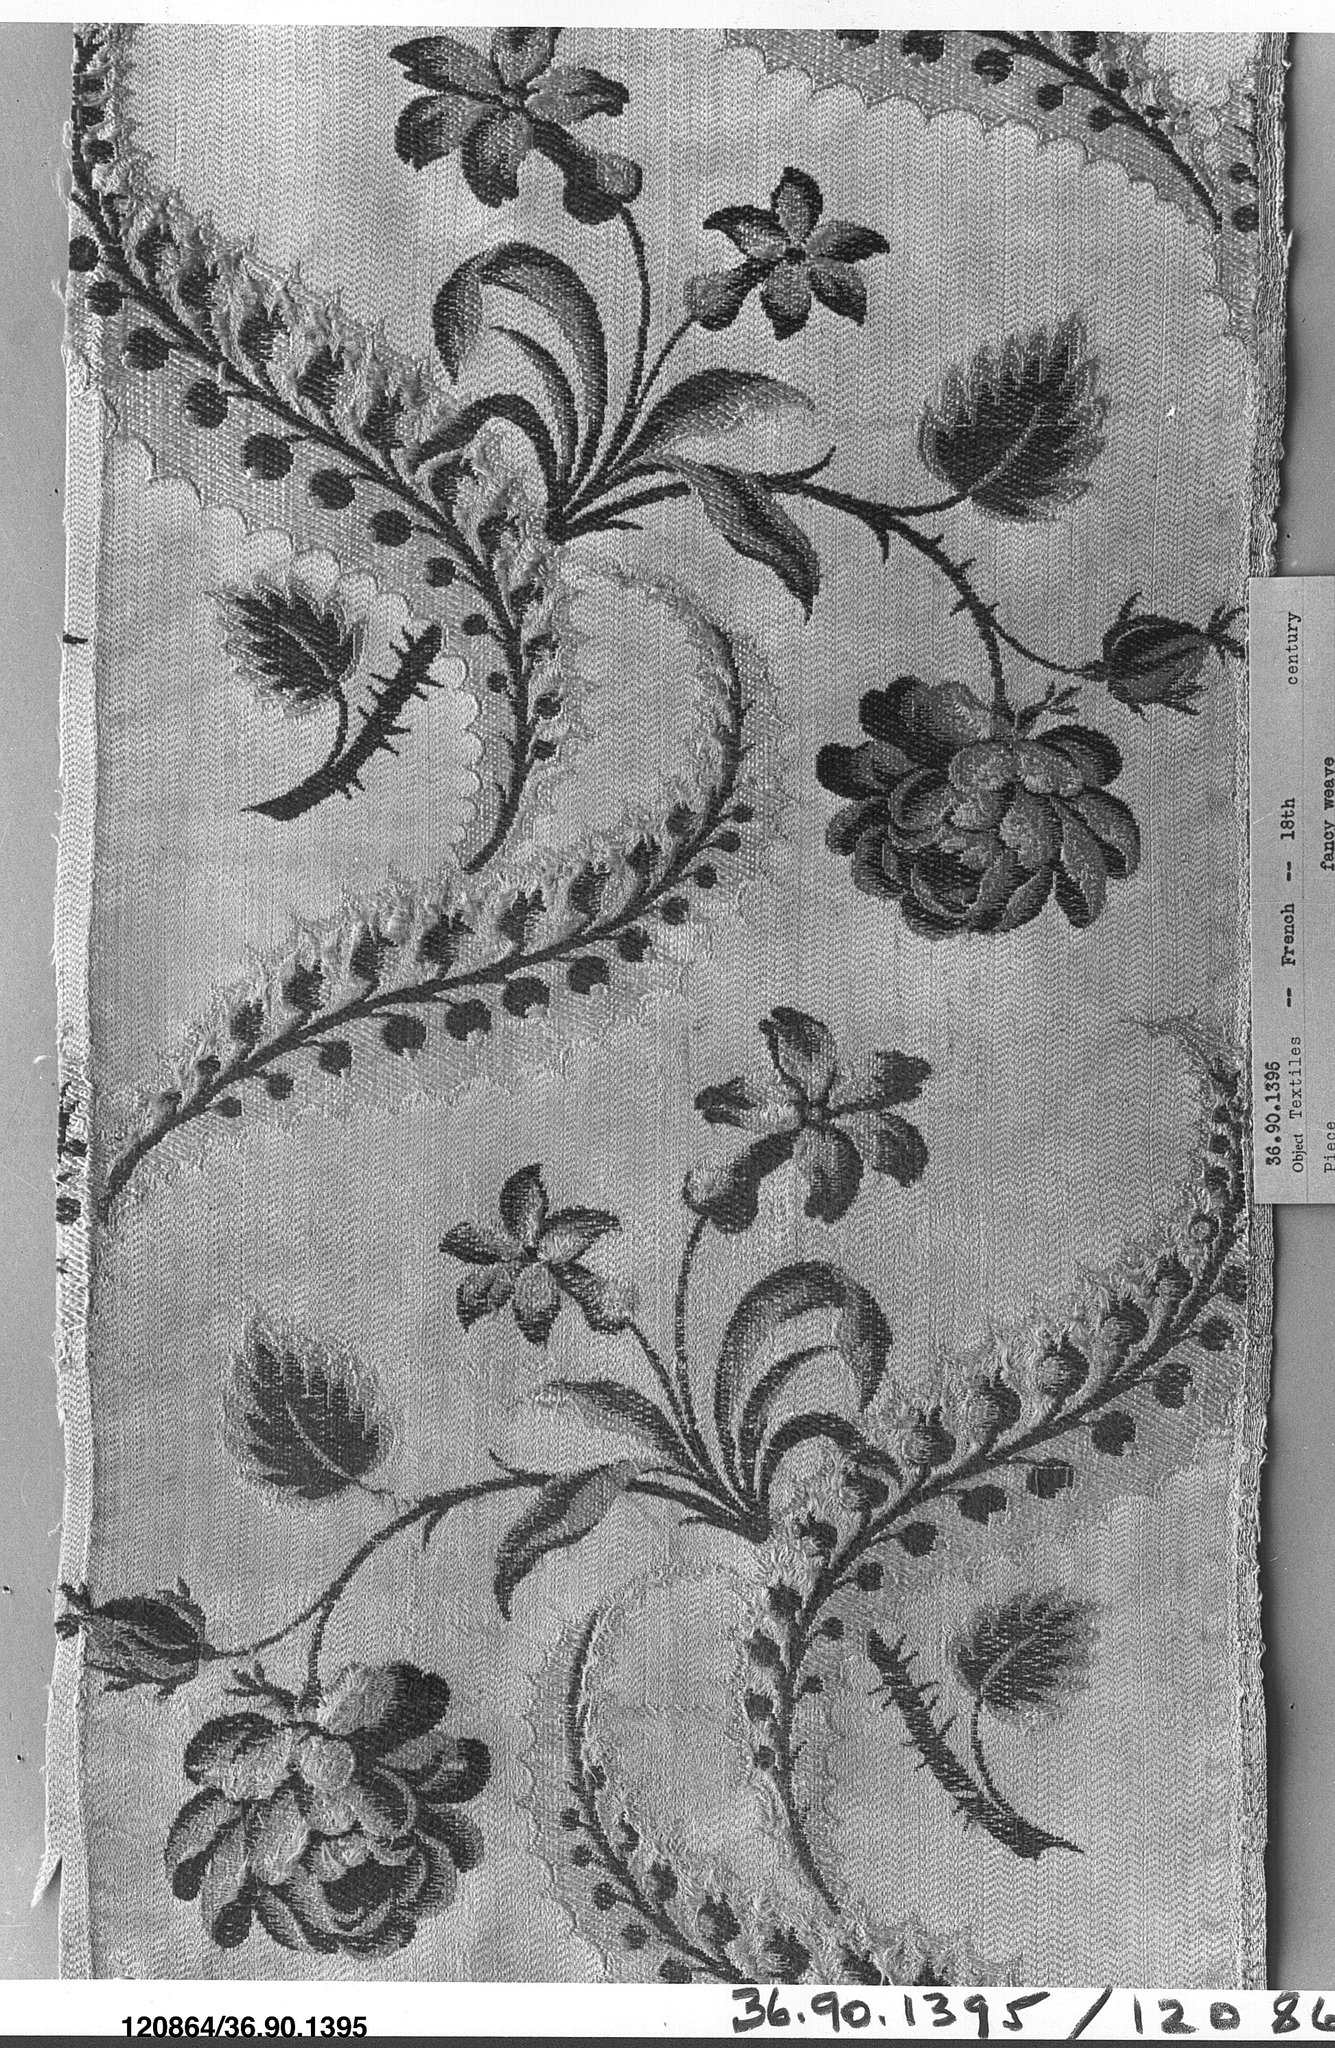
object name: piece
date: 1750-1760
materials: silk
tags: flowers,leaves